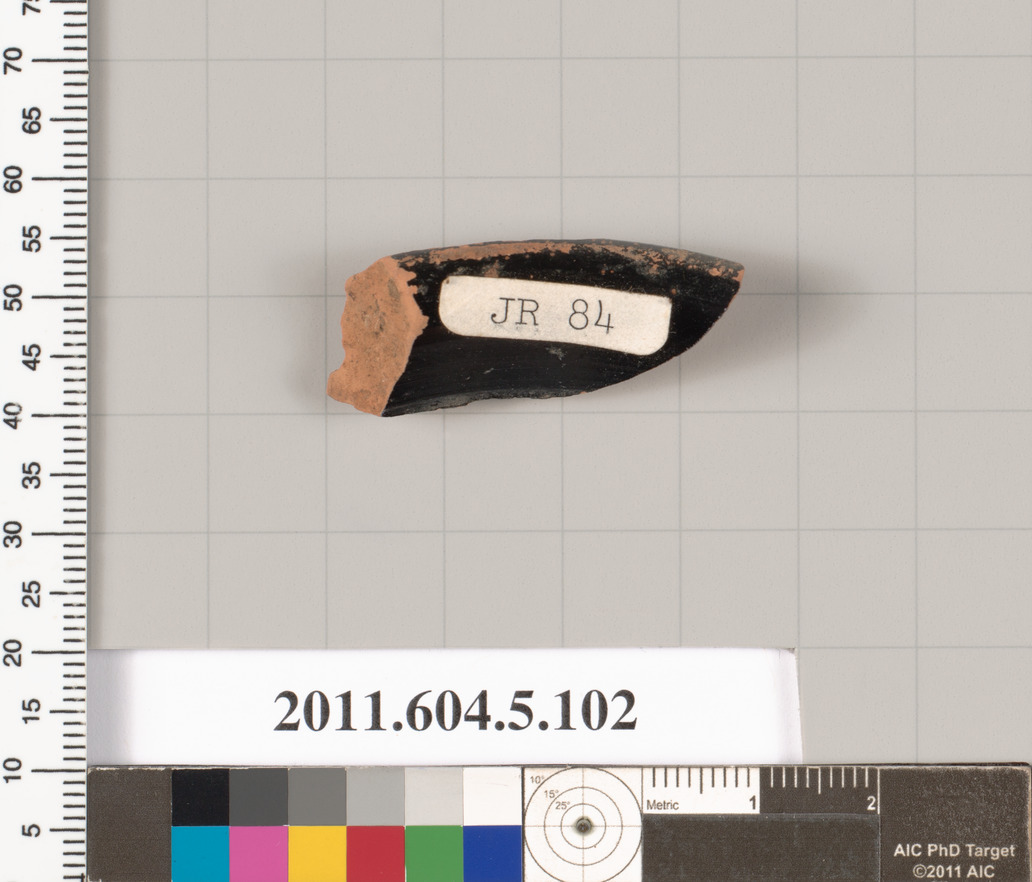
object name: kylix fragment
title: Terracotta fragment of a stemless kylix (drinking cup)?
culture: greek, attic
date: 470-450 BCE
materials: terracotta